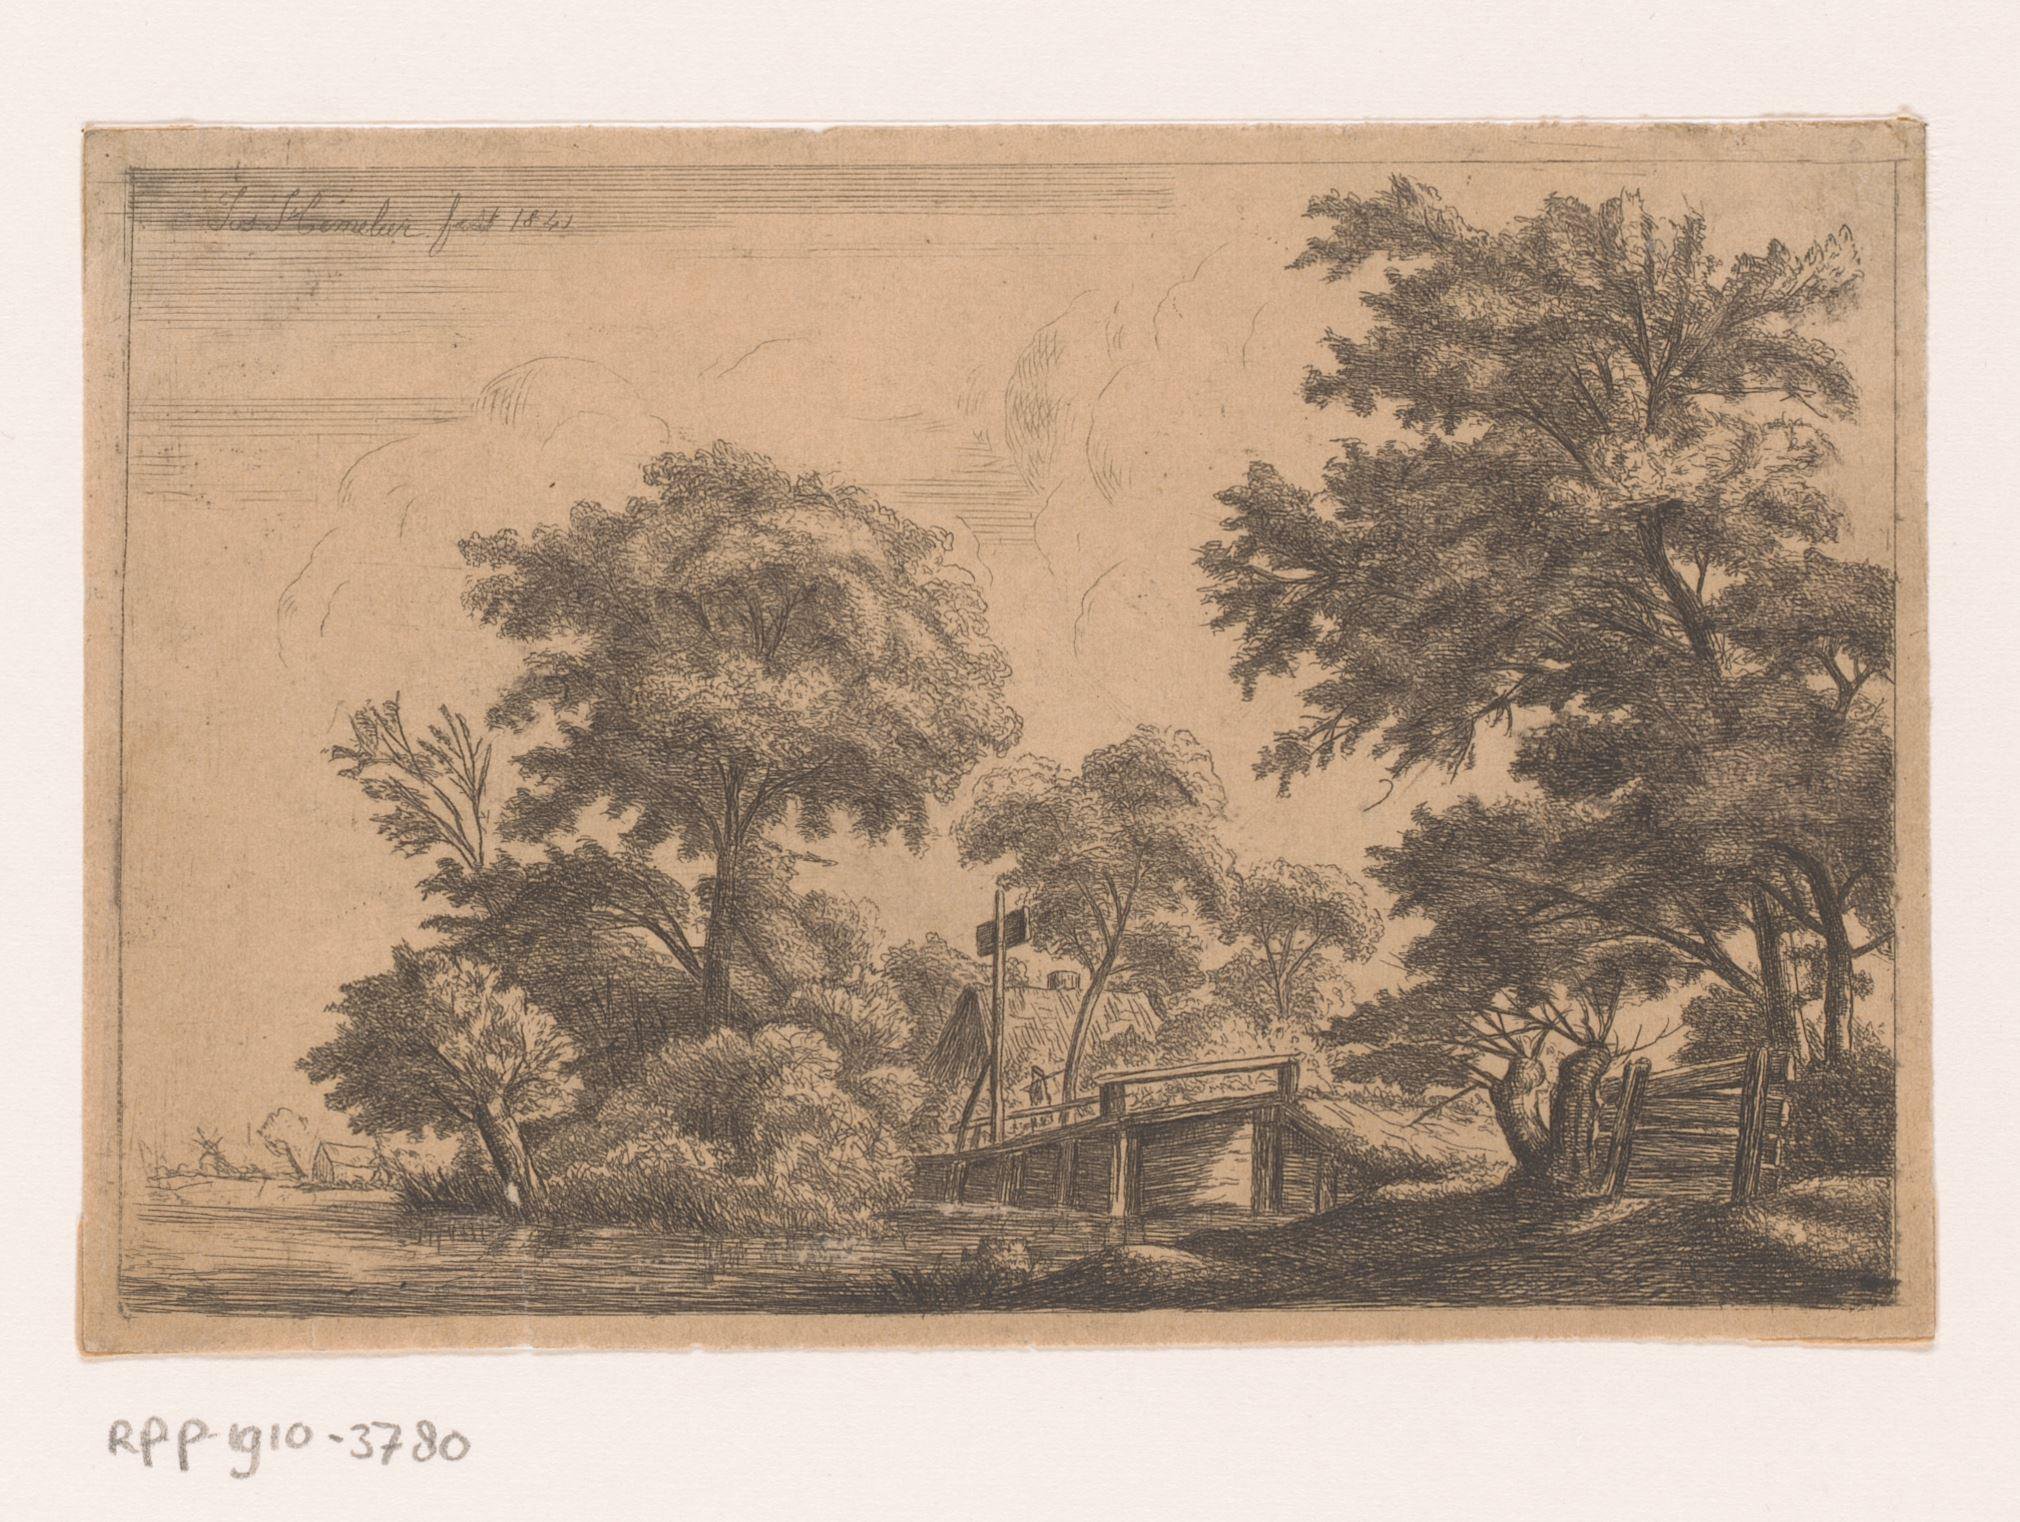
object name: print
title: Landschap met brug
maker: jos hemeleer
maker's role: print maker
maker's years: 1830-1873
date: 1841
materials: paper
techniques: etching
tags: landscape with bridge, viaduct or aqueduct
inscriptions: date